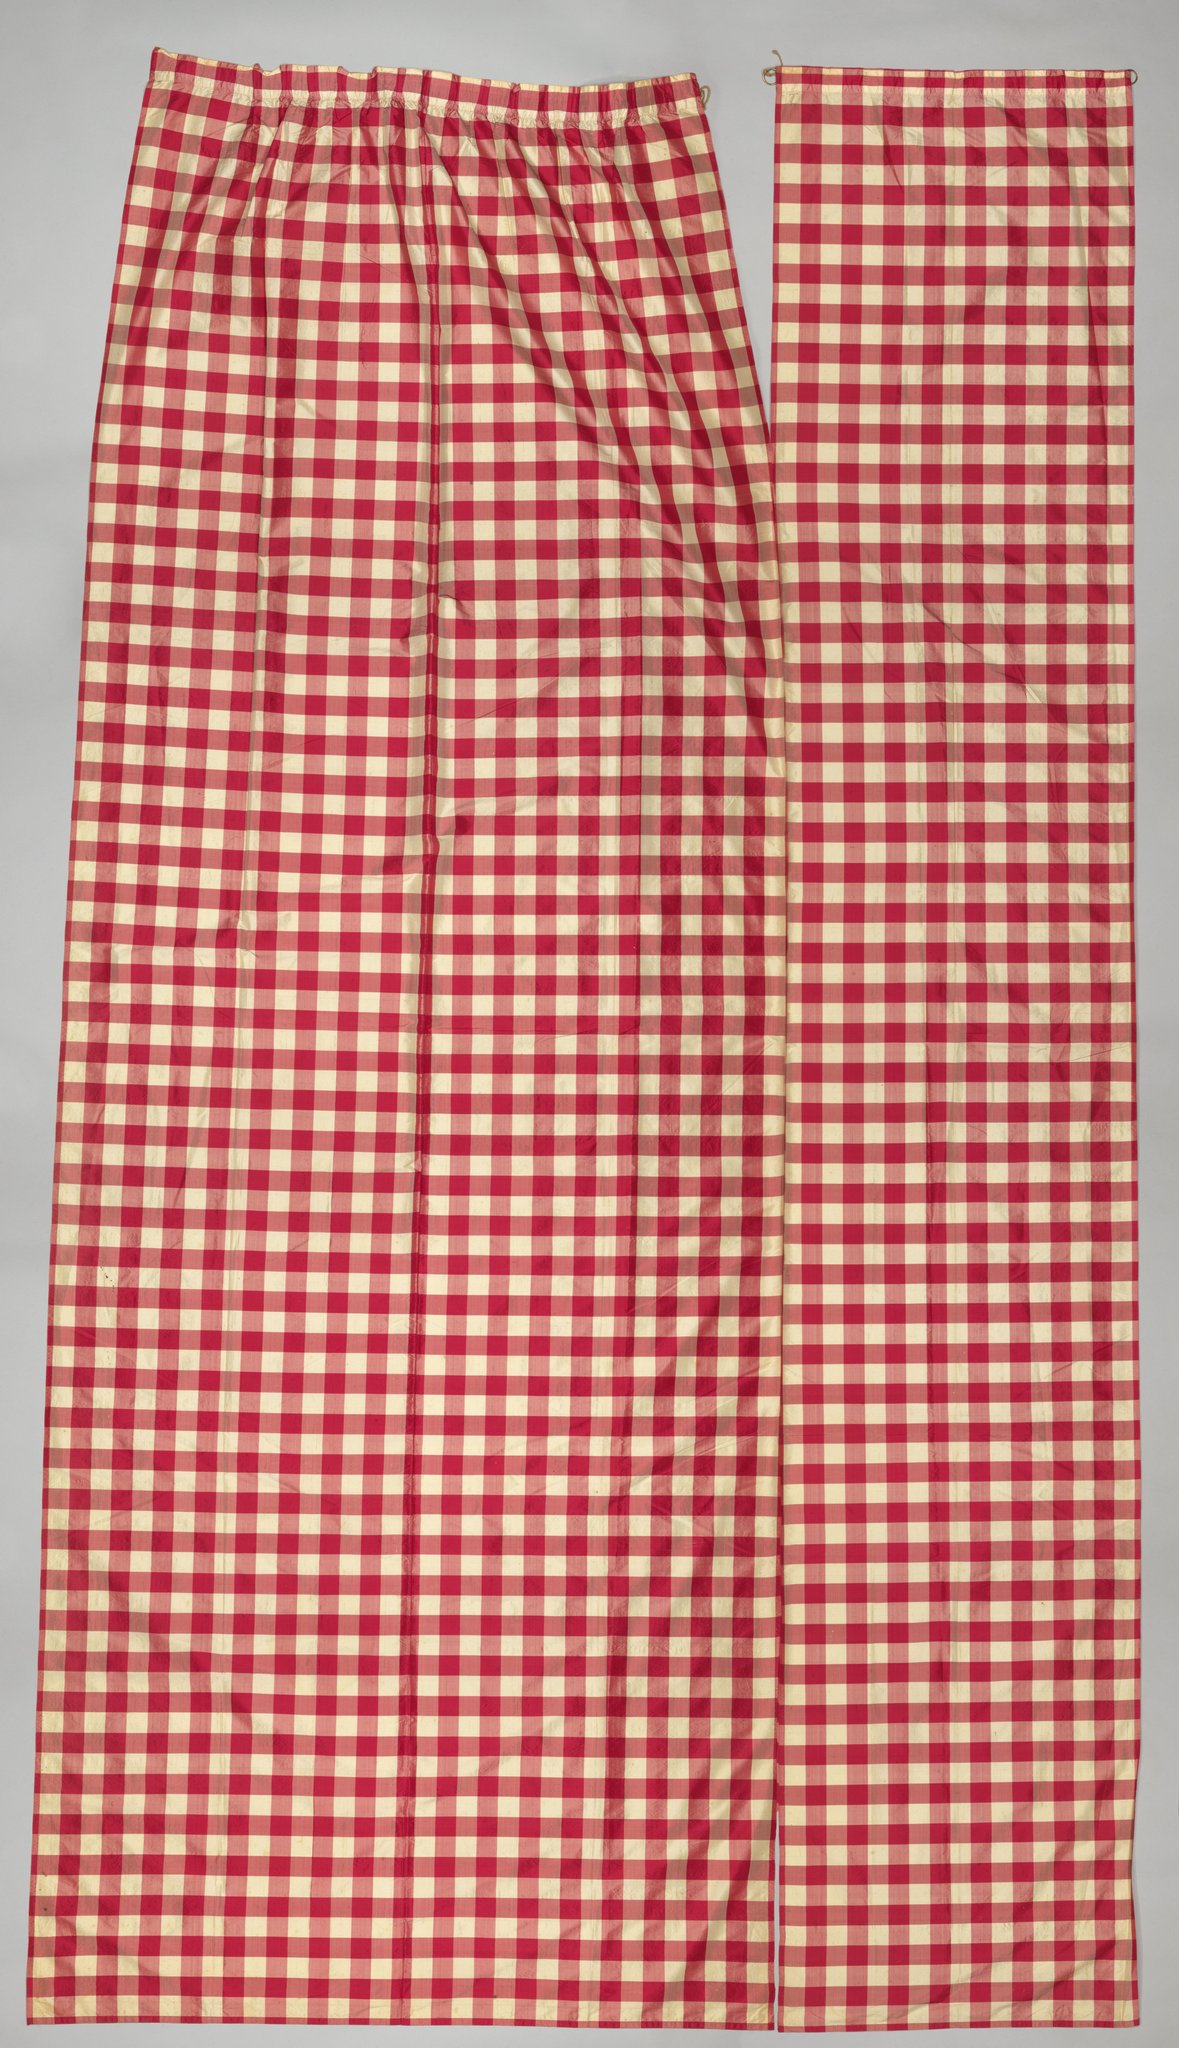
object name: curtain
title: Rood-wit geblokt gordijn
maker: Anonymous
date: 1776-1800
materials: linen, silk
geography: northern netherlands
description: Gordijn van rood-wit geblokte zijde met een gefronst hoofdje aan de bovenzijde. Aan de achterzijde bovenaan een grof linnen rand met koperen ringen. Aan de boven- onderzijde een split. Aan drie ringen, aan een uiteinde en ter weerszijden van de split zijn touwtjes bevestigd.